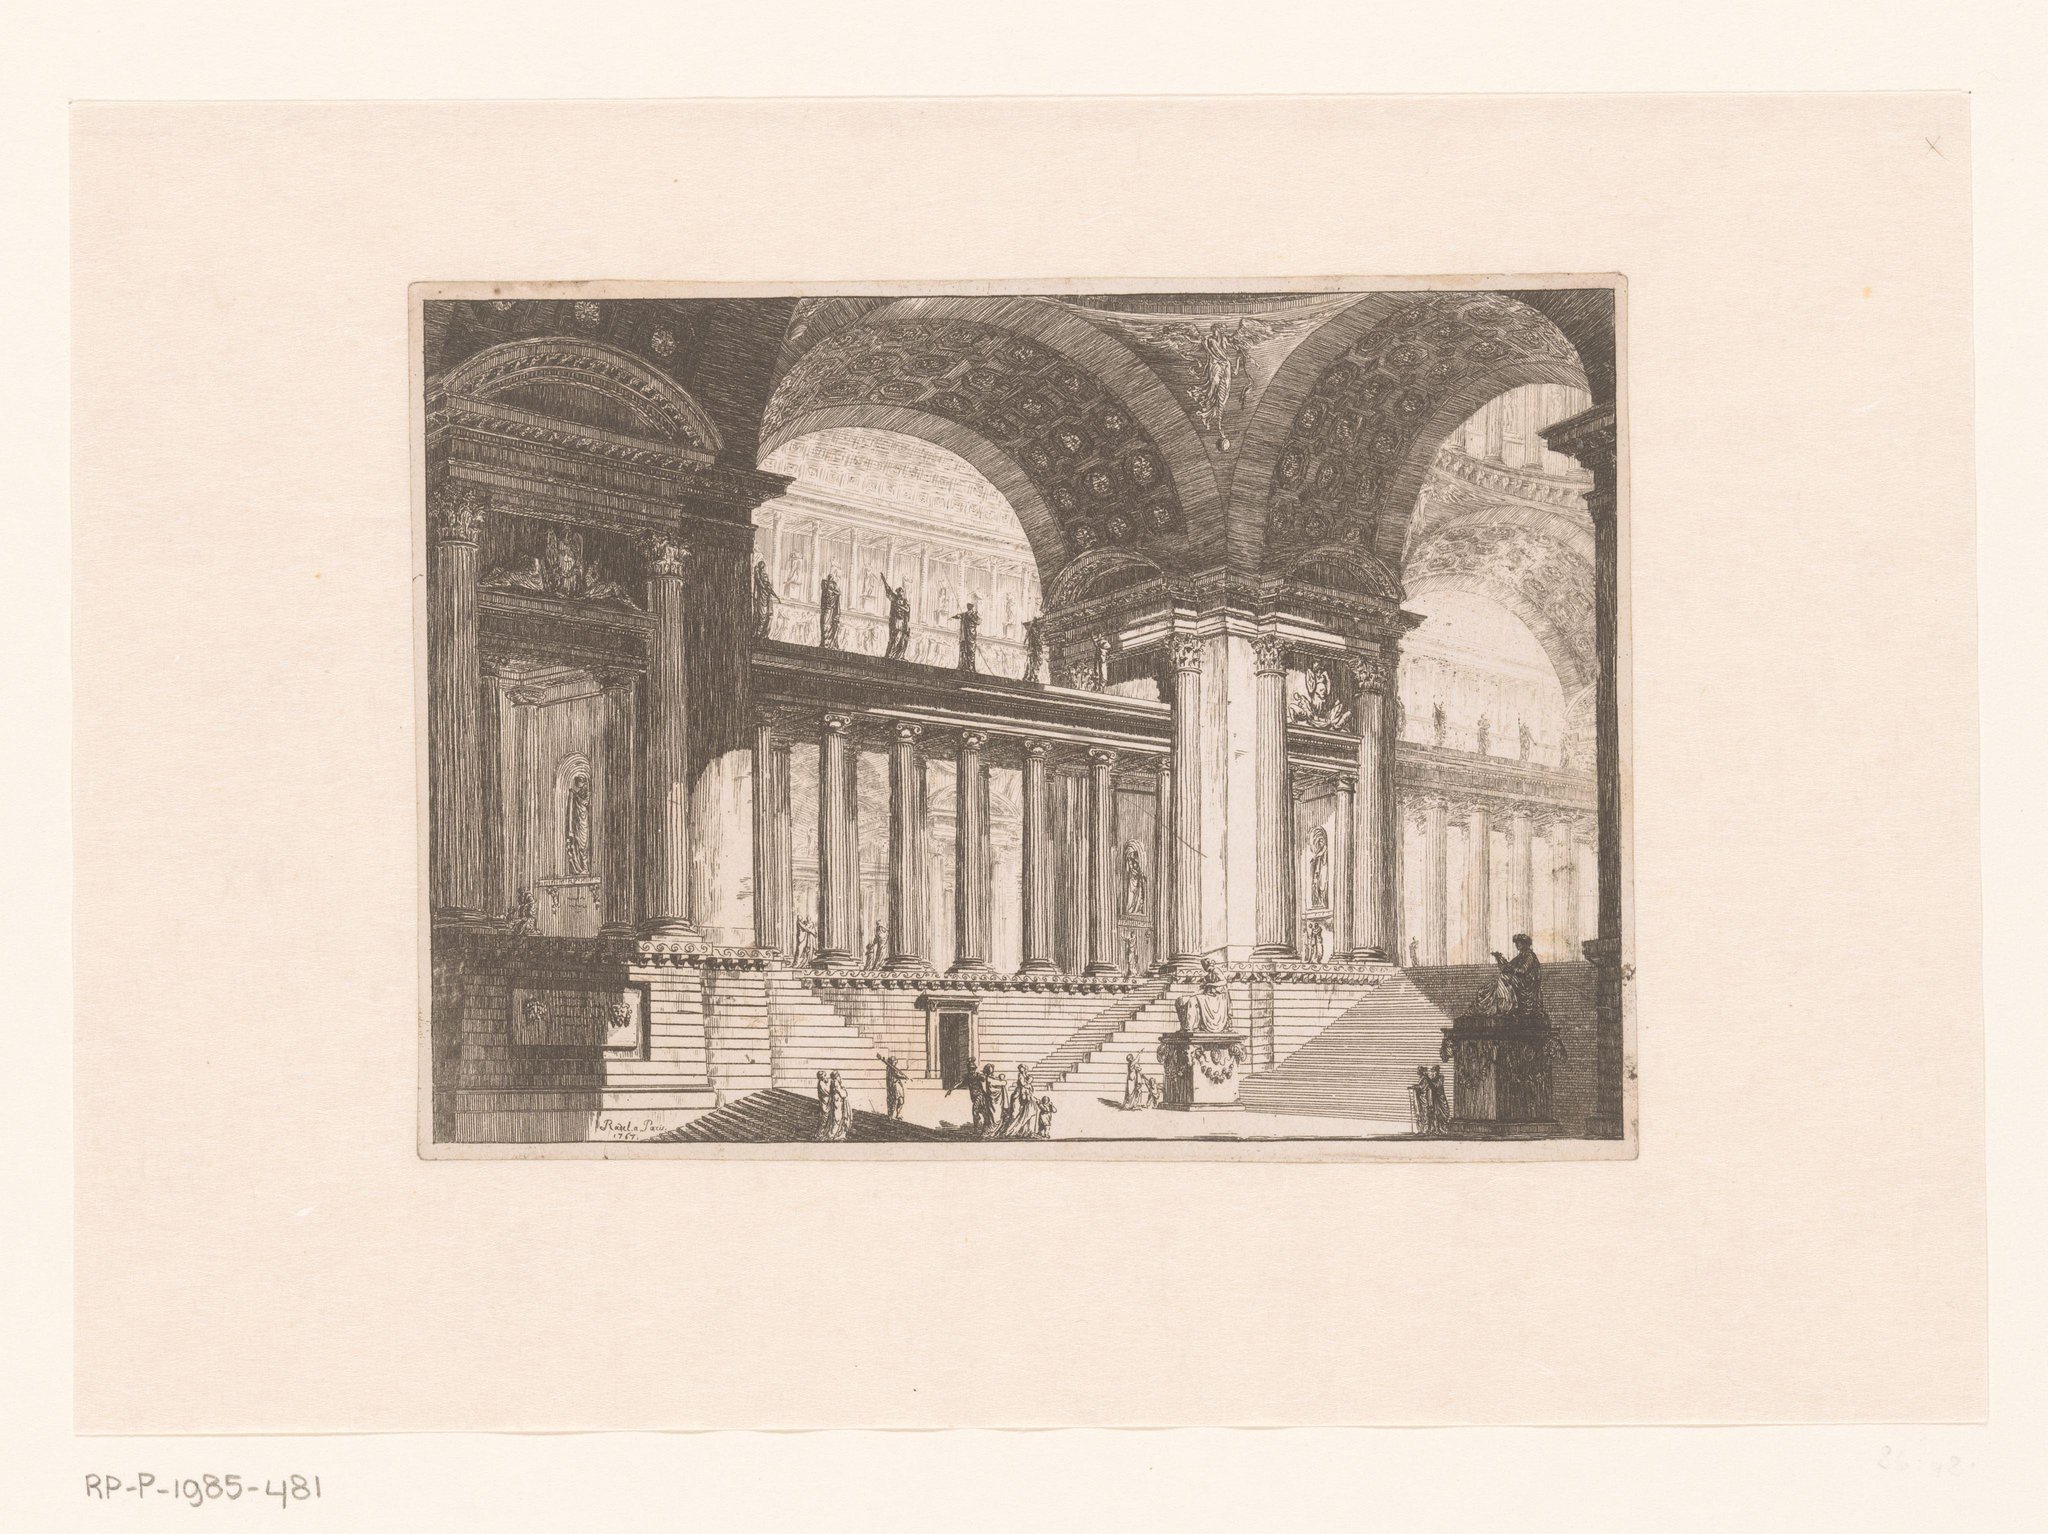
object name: print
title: Interieur van een paleis of tempel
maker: louis charles françois petit-radel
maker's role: print maker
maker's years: 1740-1818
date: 1767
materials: paper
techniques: etching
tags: architecture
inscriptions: collector's mark: Lugt 2228, collector's mark: Lugt 2760